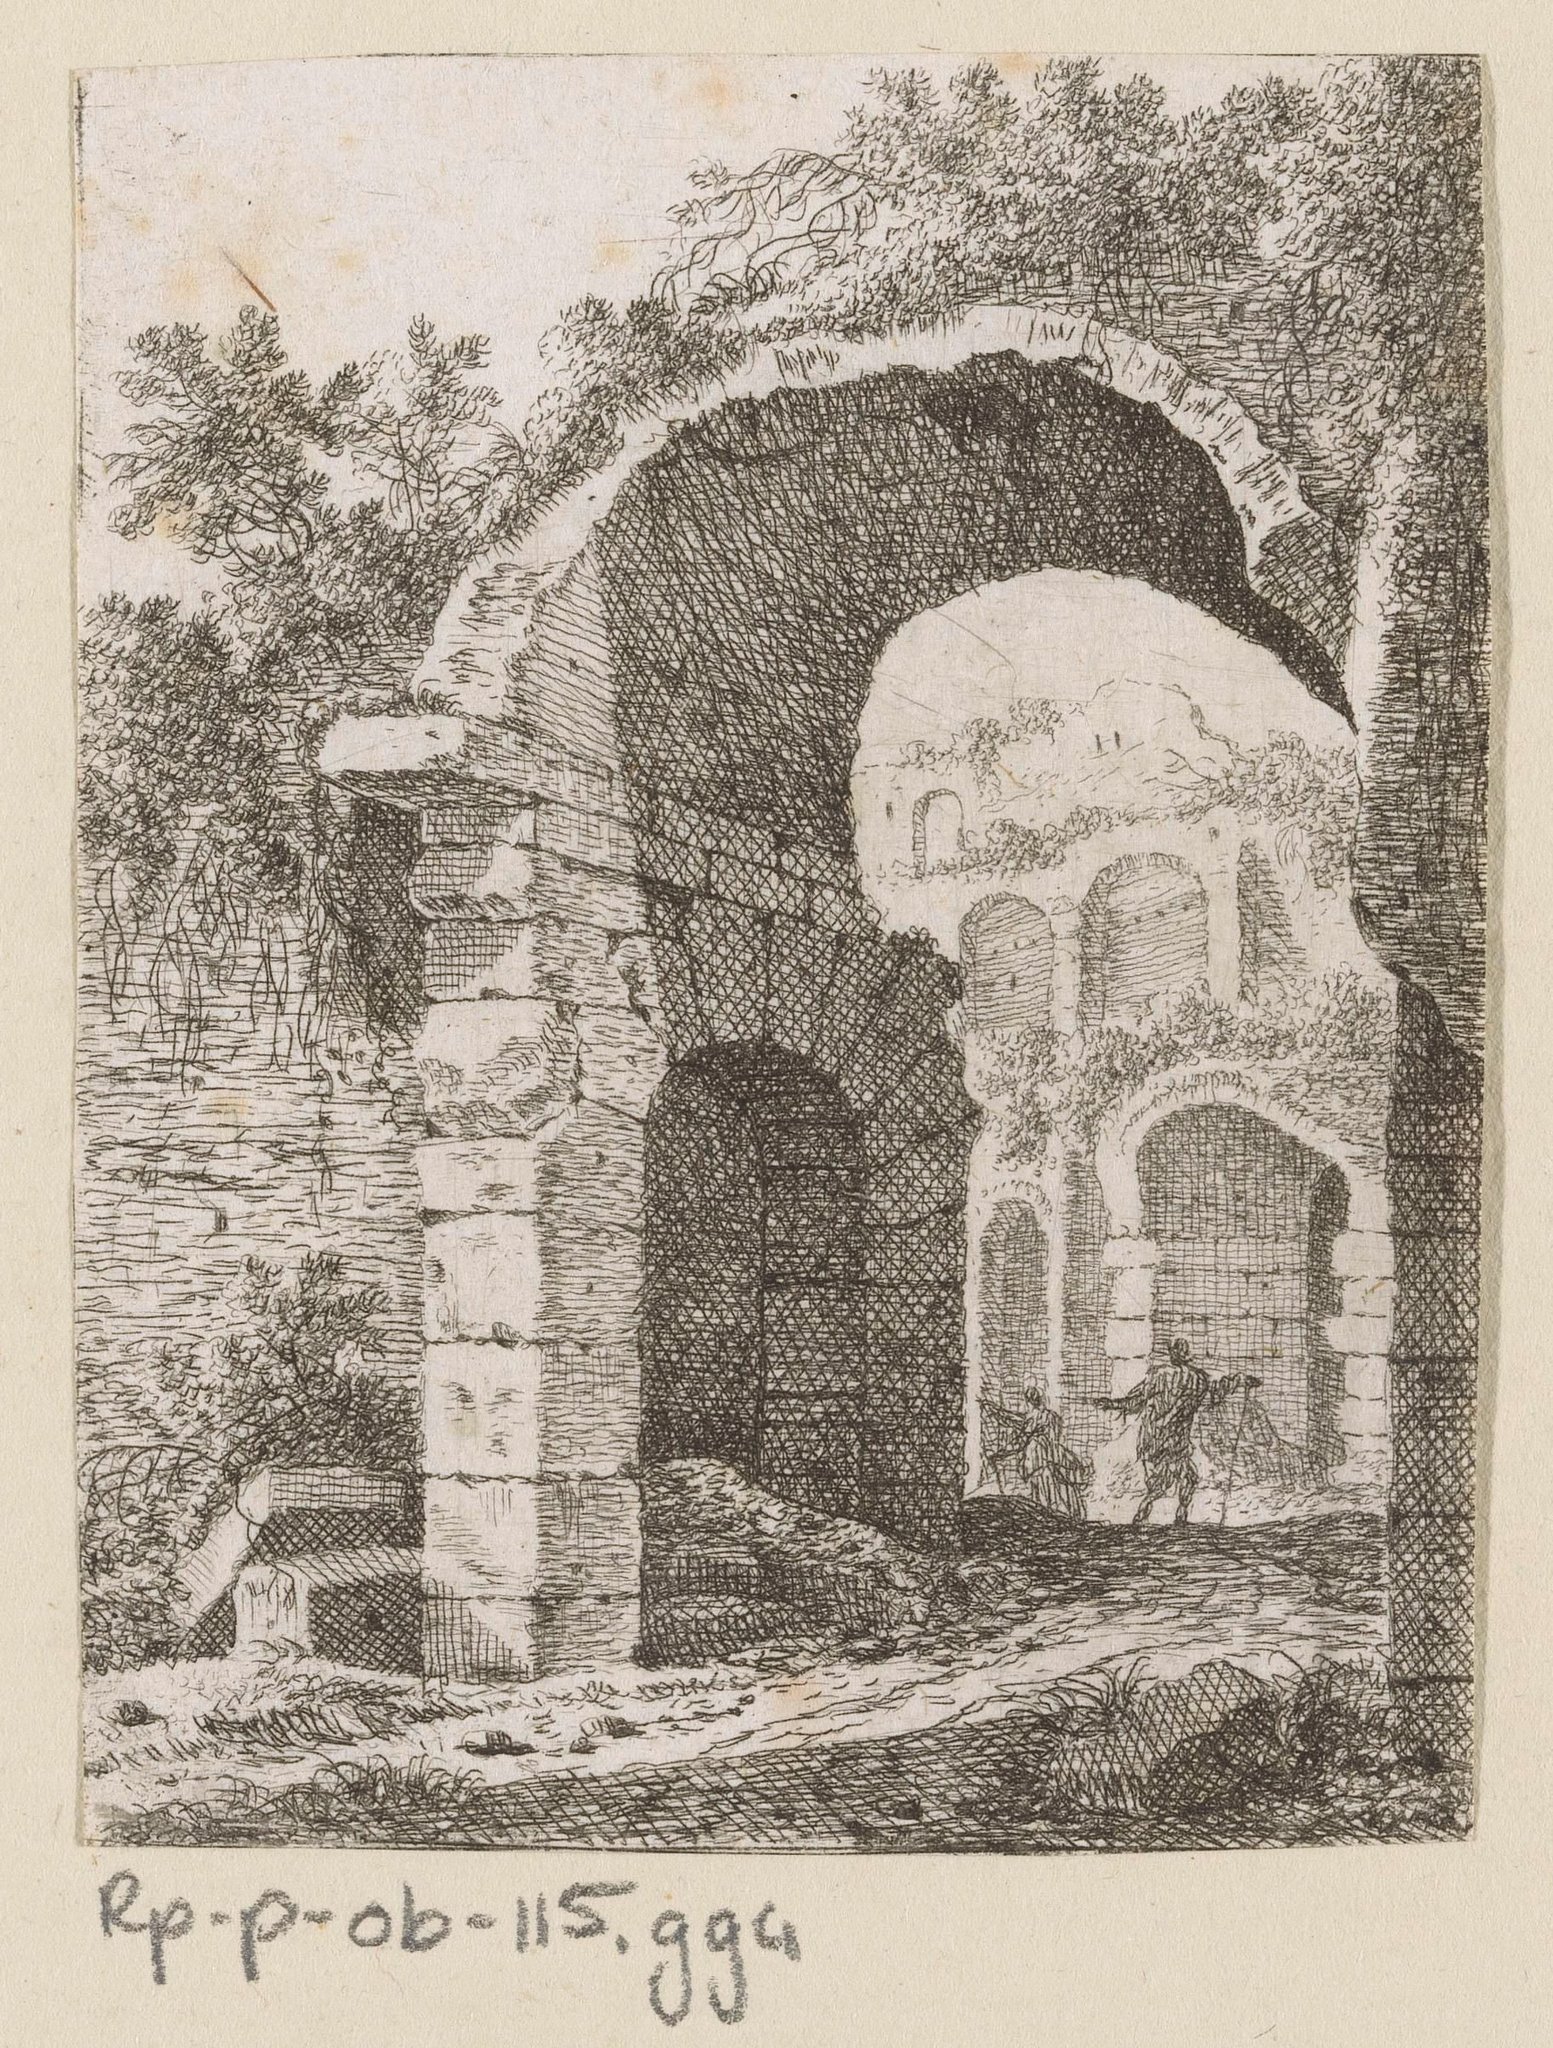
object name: print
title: Ruïne van een portico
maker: johann franz ermels (der ältere)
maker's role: draughtsman, print maker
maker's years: 1641-1693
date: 1651-1693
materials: paper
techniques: etching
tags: landscape with ruins, arcade ~ architecture, rome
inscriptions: collector's mark: Lugt 240